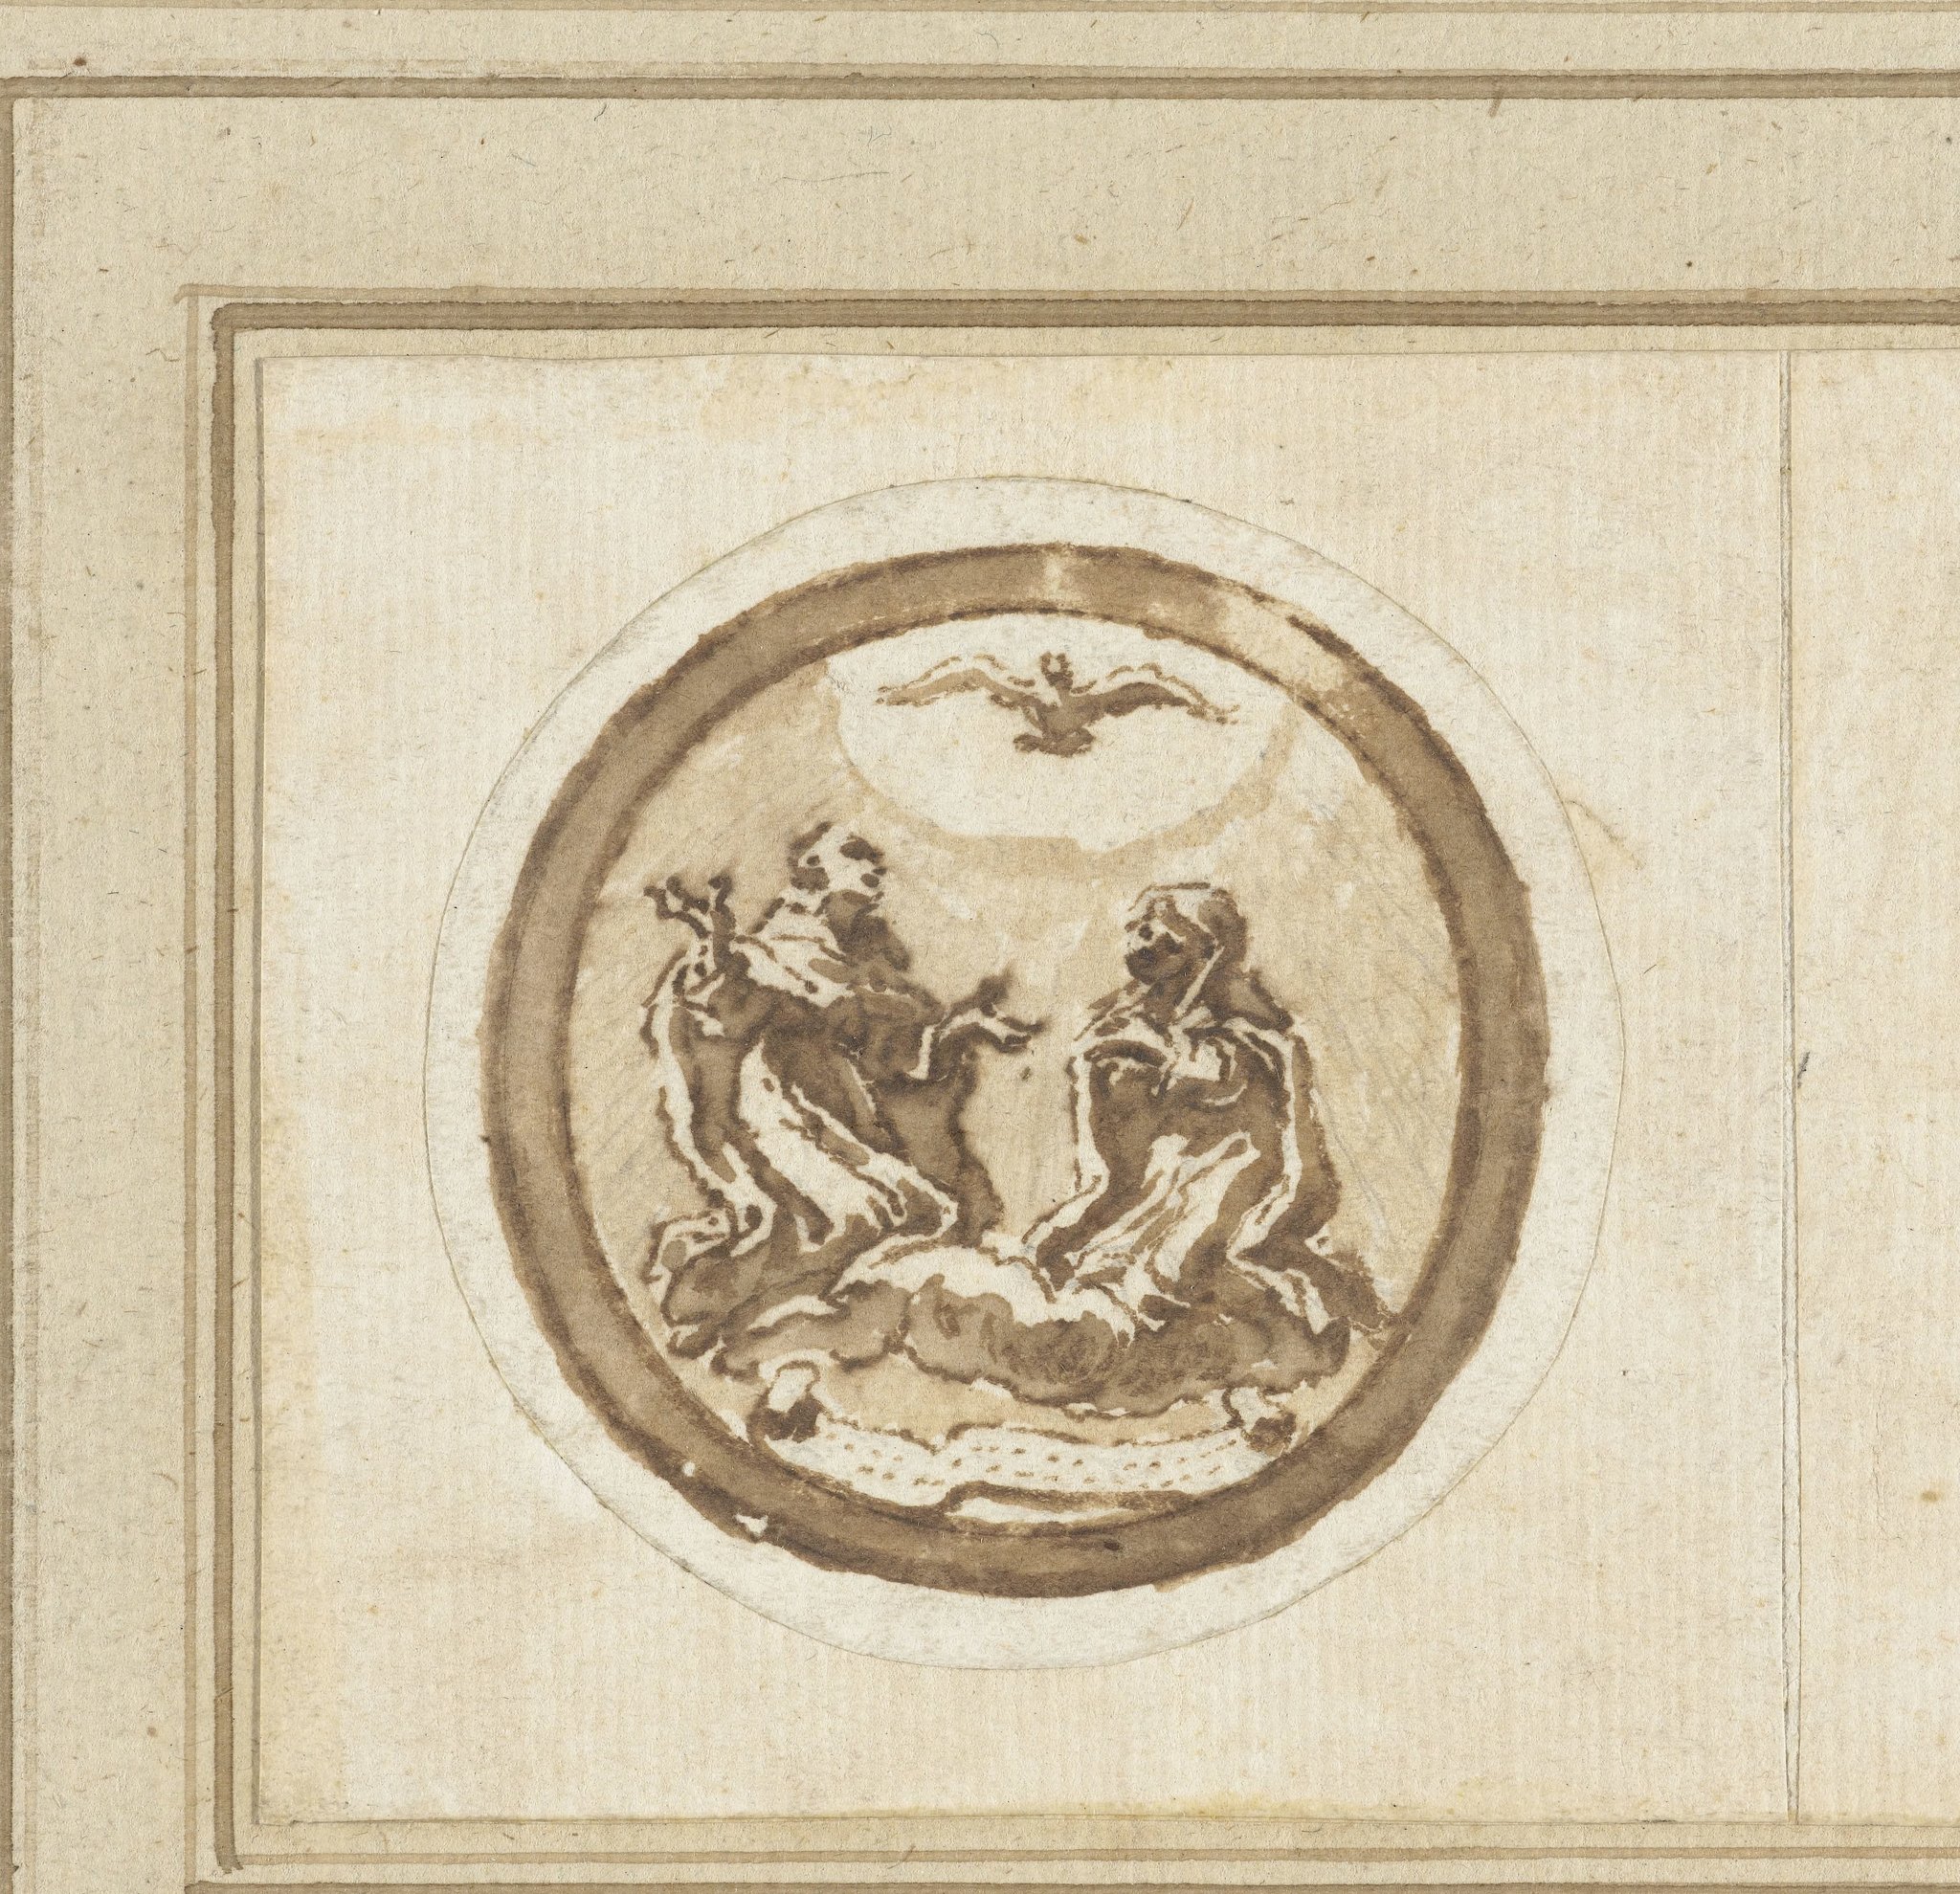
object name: design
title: Ontwerp voor een gedenkpenning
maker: giovanni lorenzo bernini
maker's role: draughtsman, painter, sculptor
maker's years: 1598-1680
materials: ink, paper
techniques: brush, pen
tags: trade token, private coin, medal (considered as a piece of sculpture, regardless of its specific function)